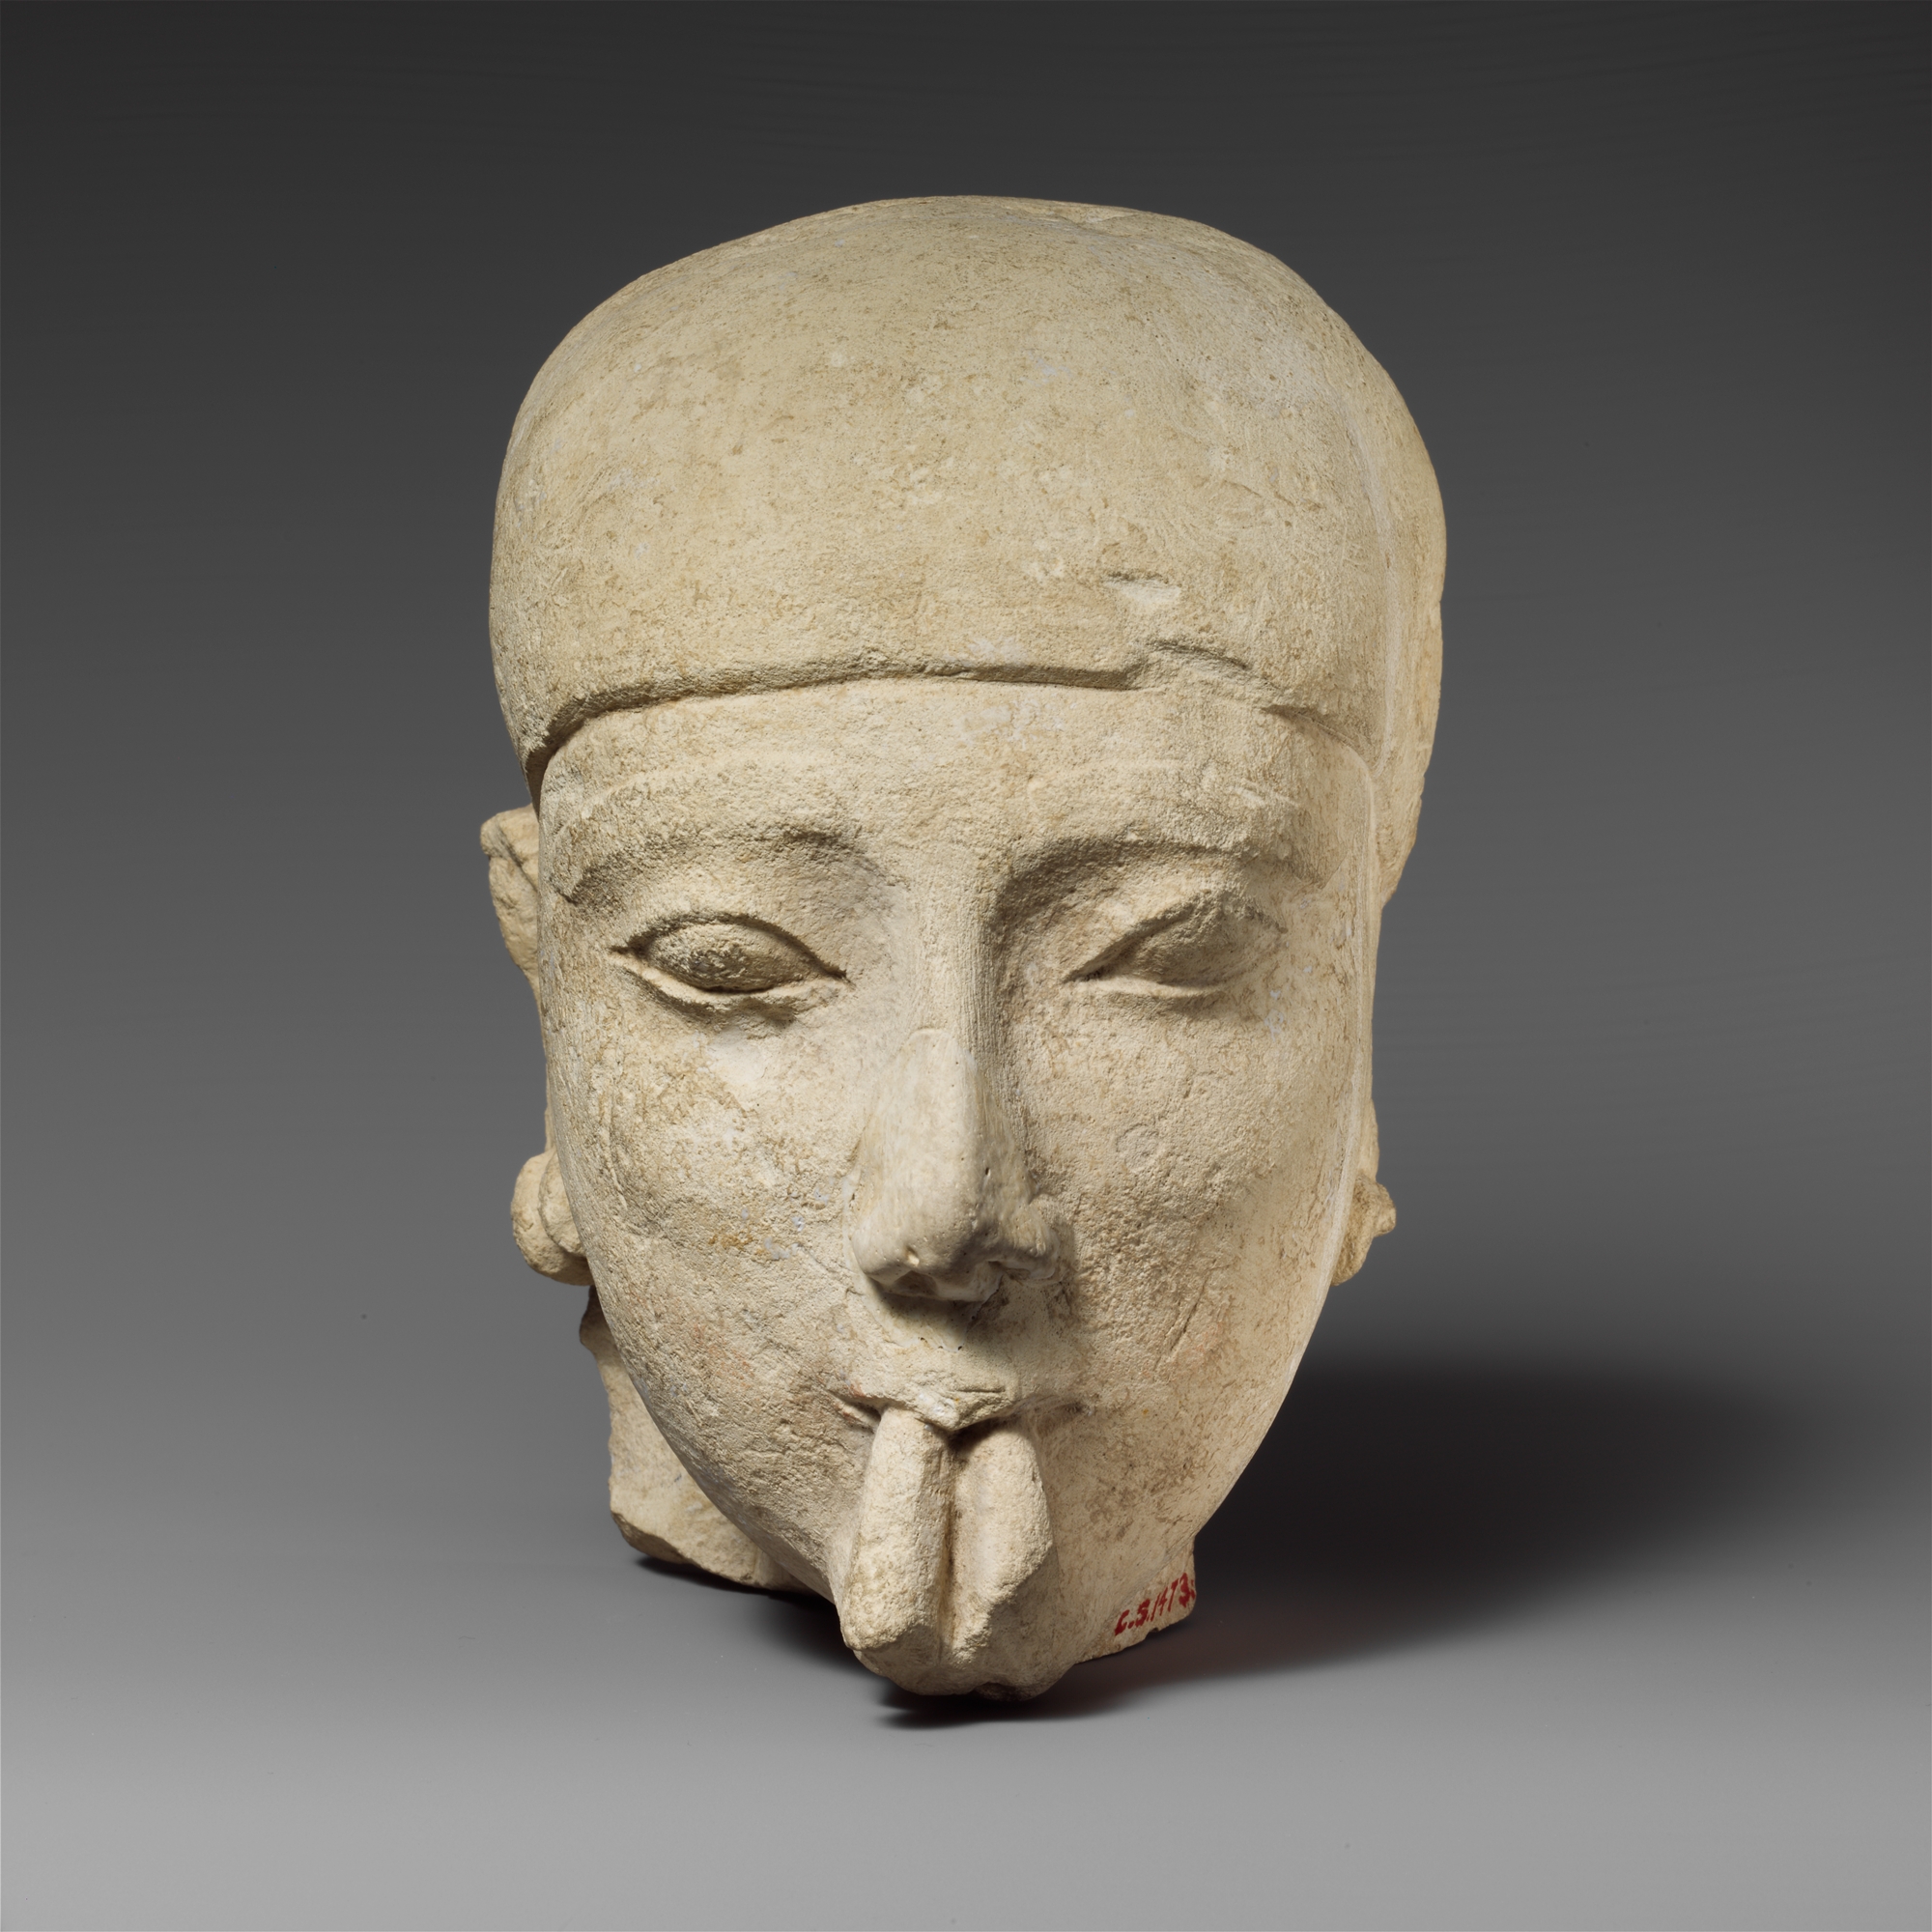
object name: head of a flute player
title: Limestone head of a male aulos player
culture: cypriot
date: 575-551 BCE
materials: limestone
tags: heads,men